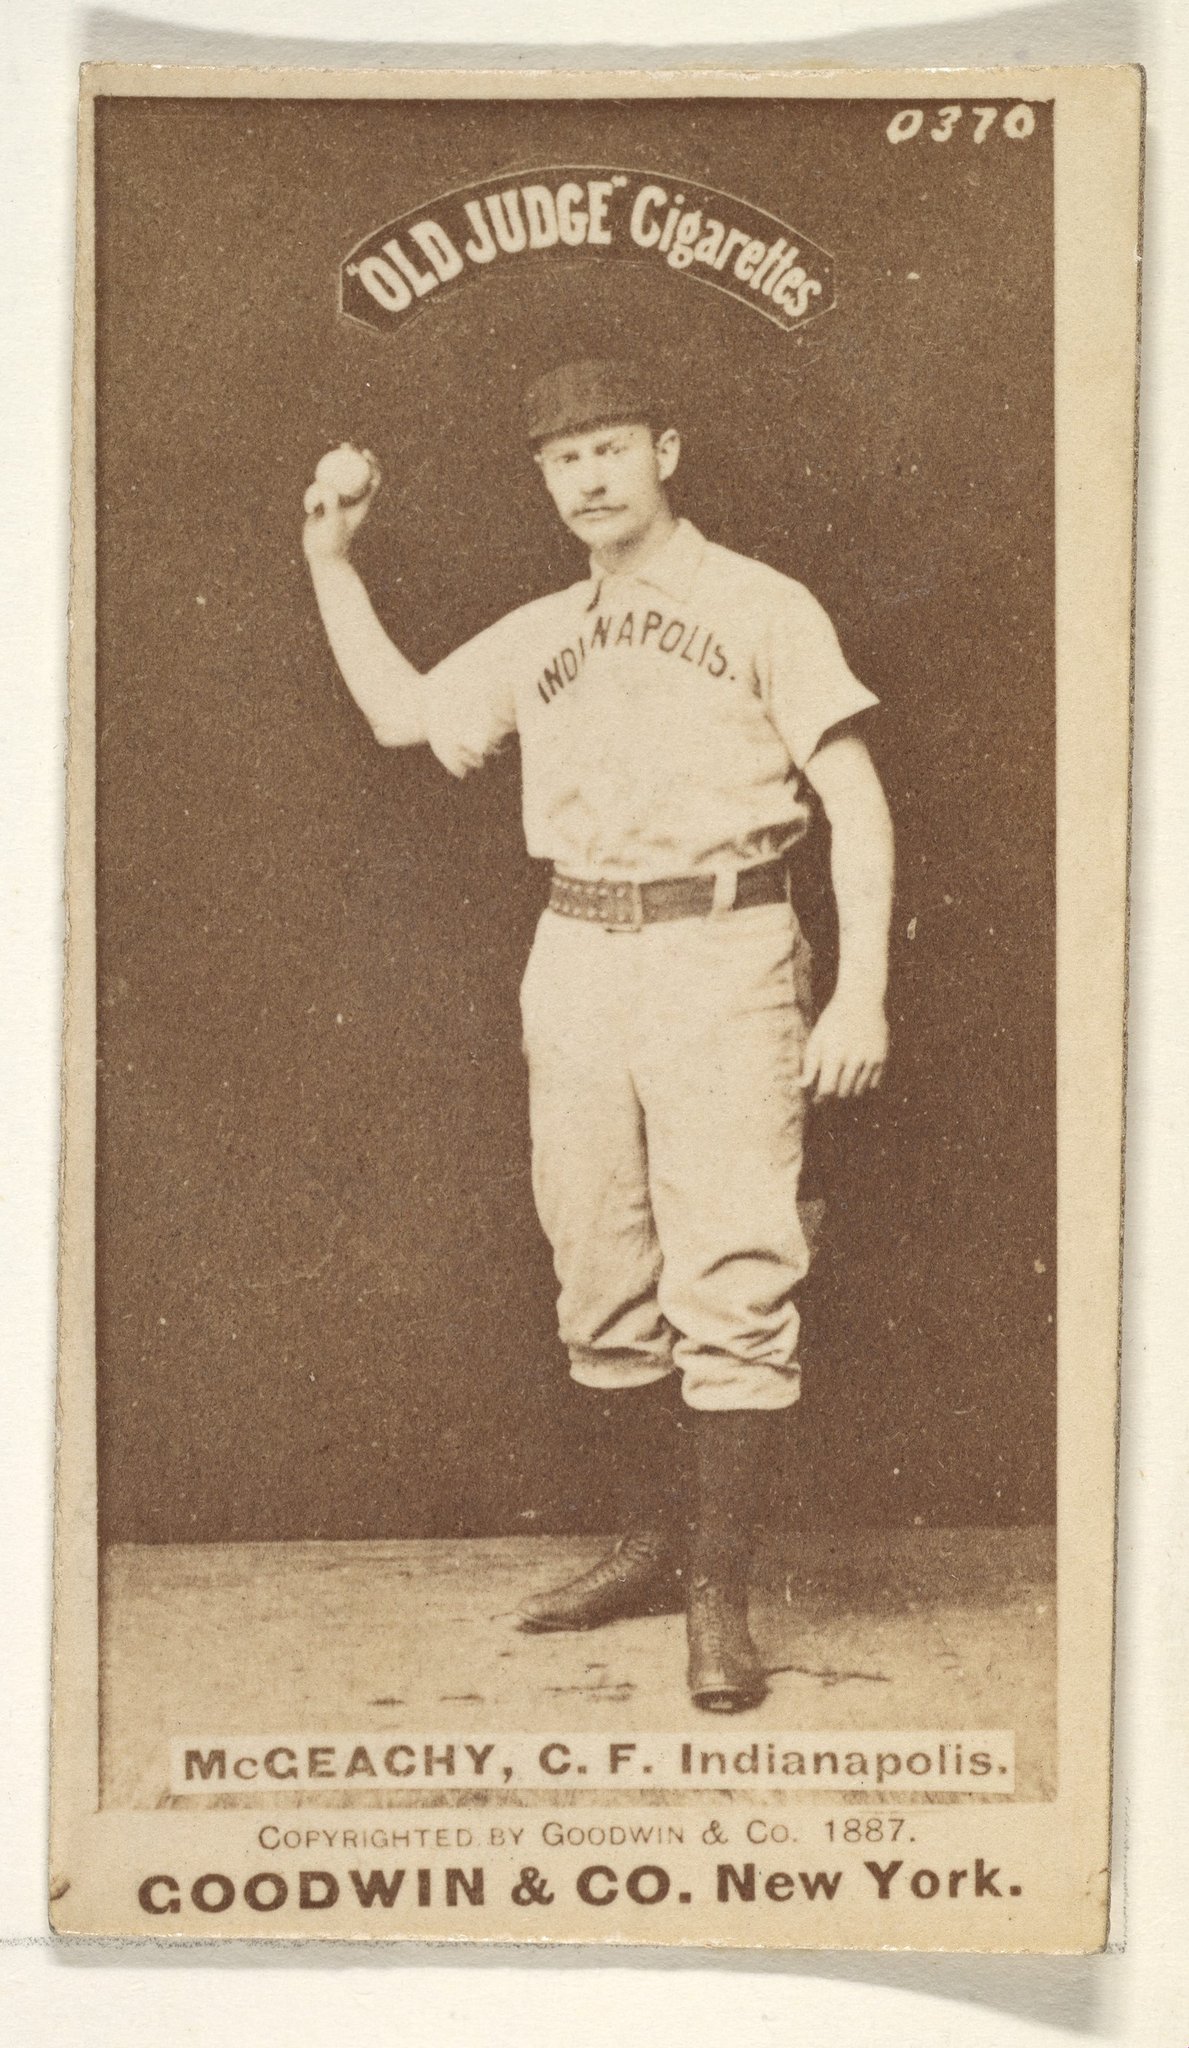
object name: baseball card, photograph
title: Jack McGeachey, Center Field, Indianapolis, from the Old Judge series (N172) for Old Judge Cigarettes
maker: goodwin & company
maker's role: publisher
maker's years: 1850-1950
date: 1887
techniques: albumen silver print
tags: men,portraits,baseball,athletes